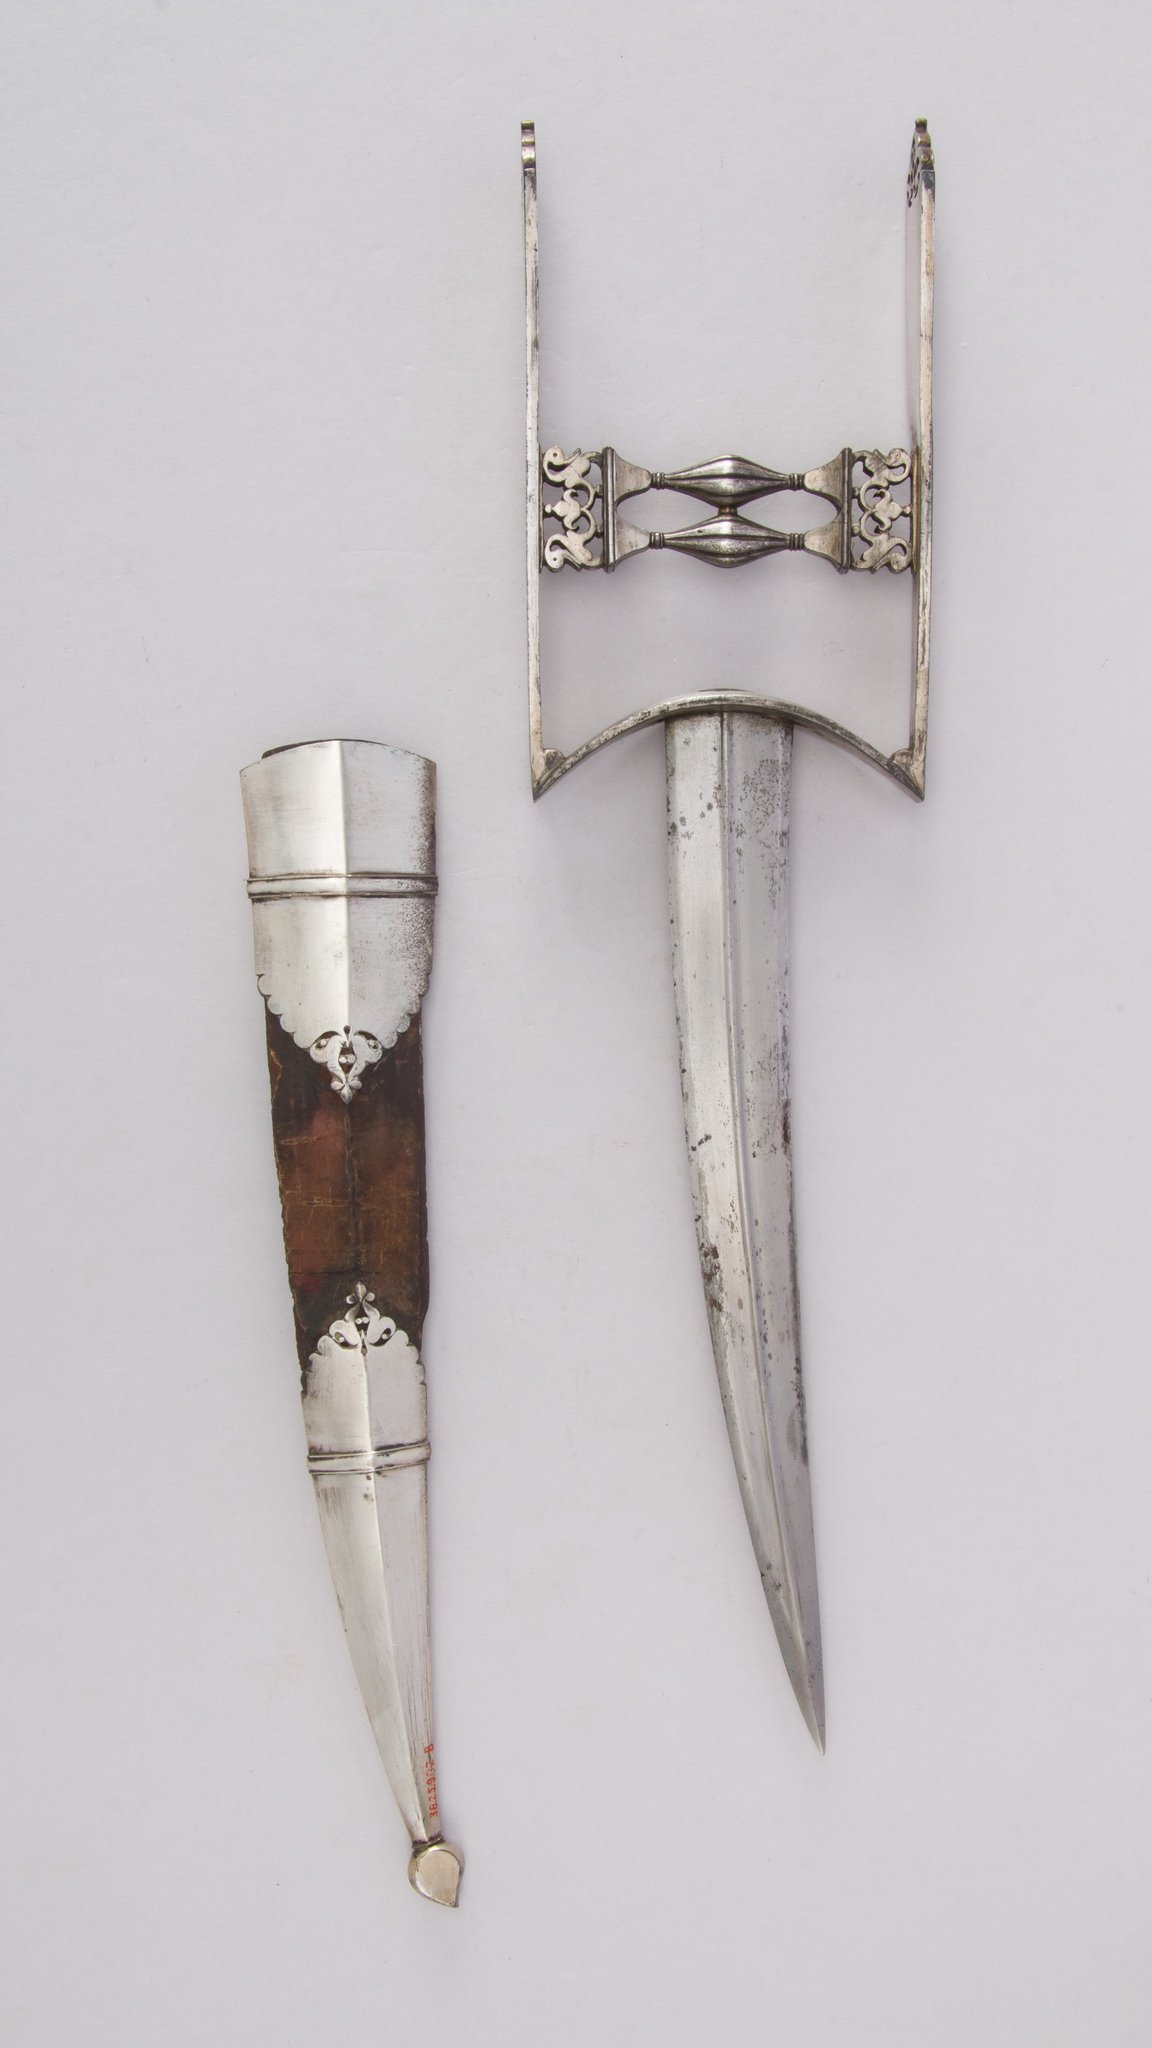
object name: dagger with sheath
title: Dagger (Katar) with Sheath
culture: north indian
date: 1701-1800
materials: silver, steel, velvet, wood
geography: india